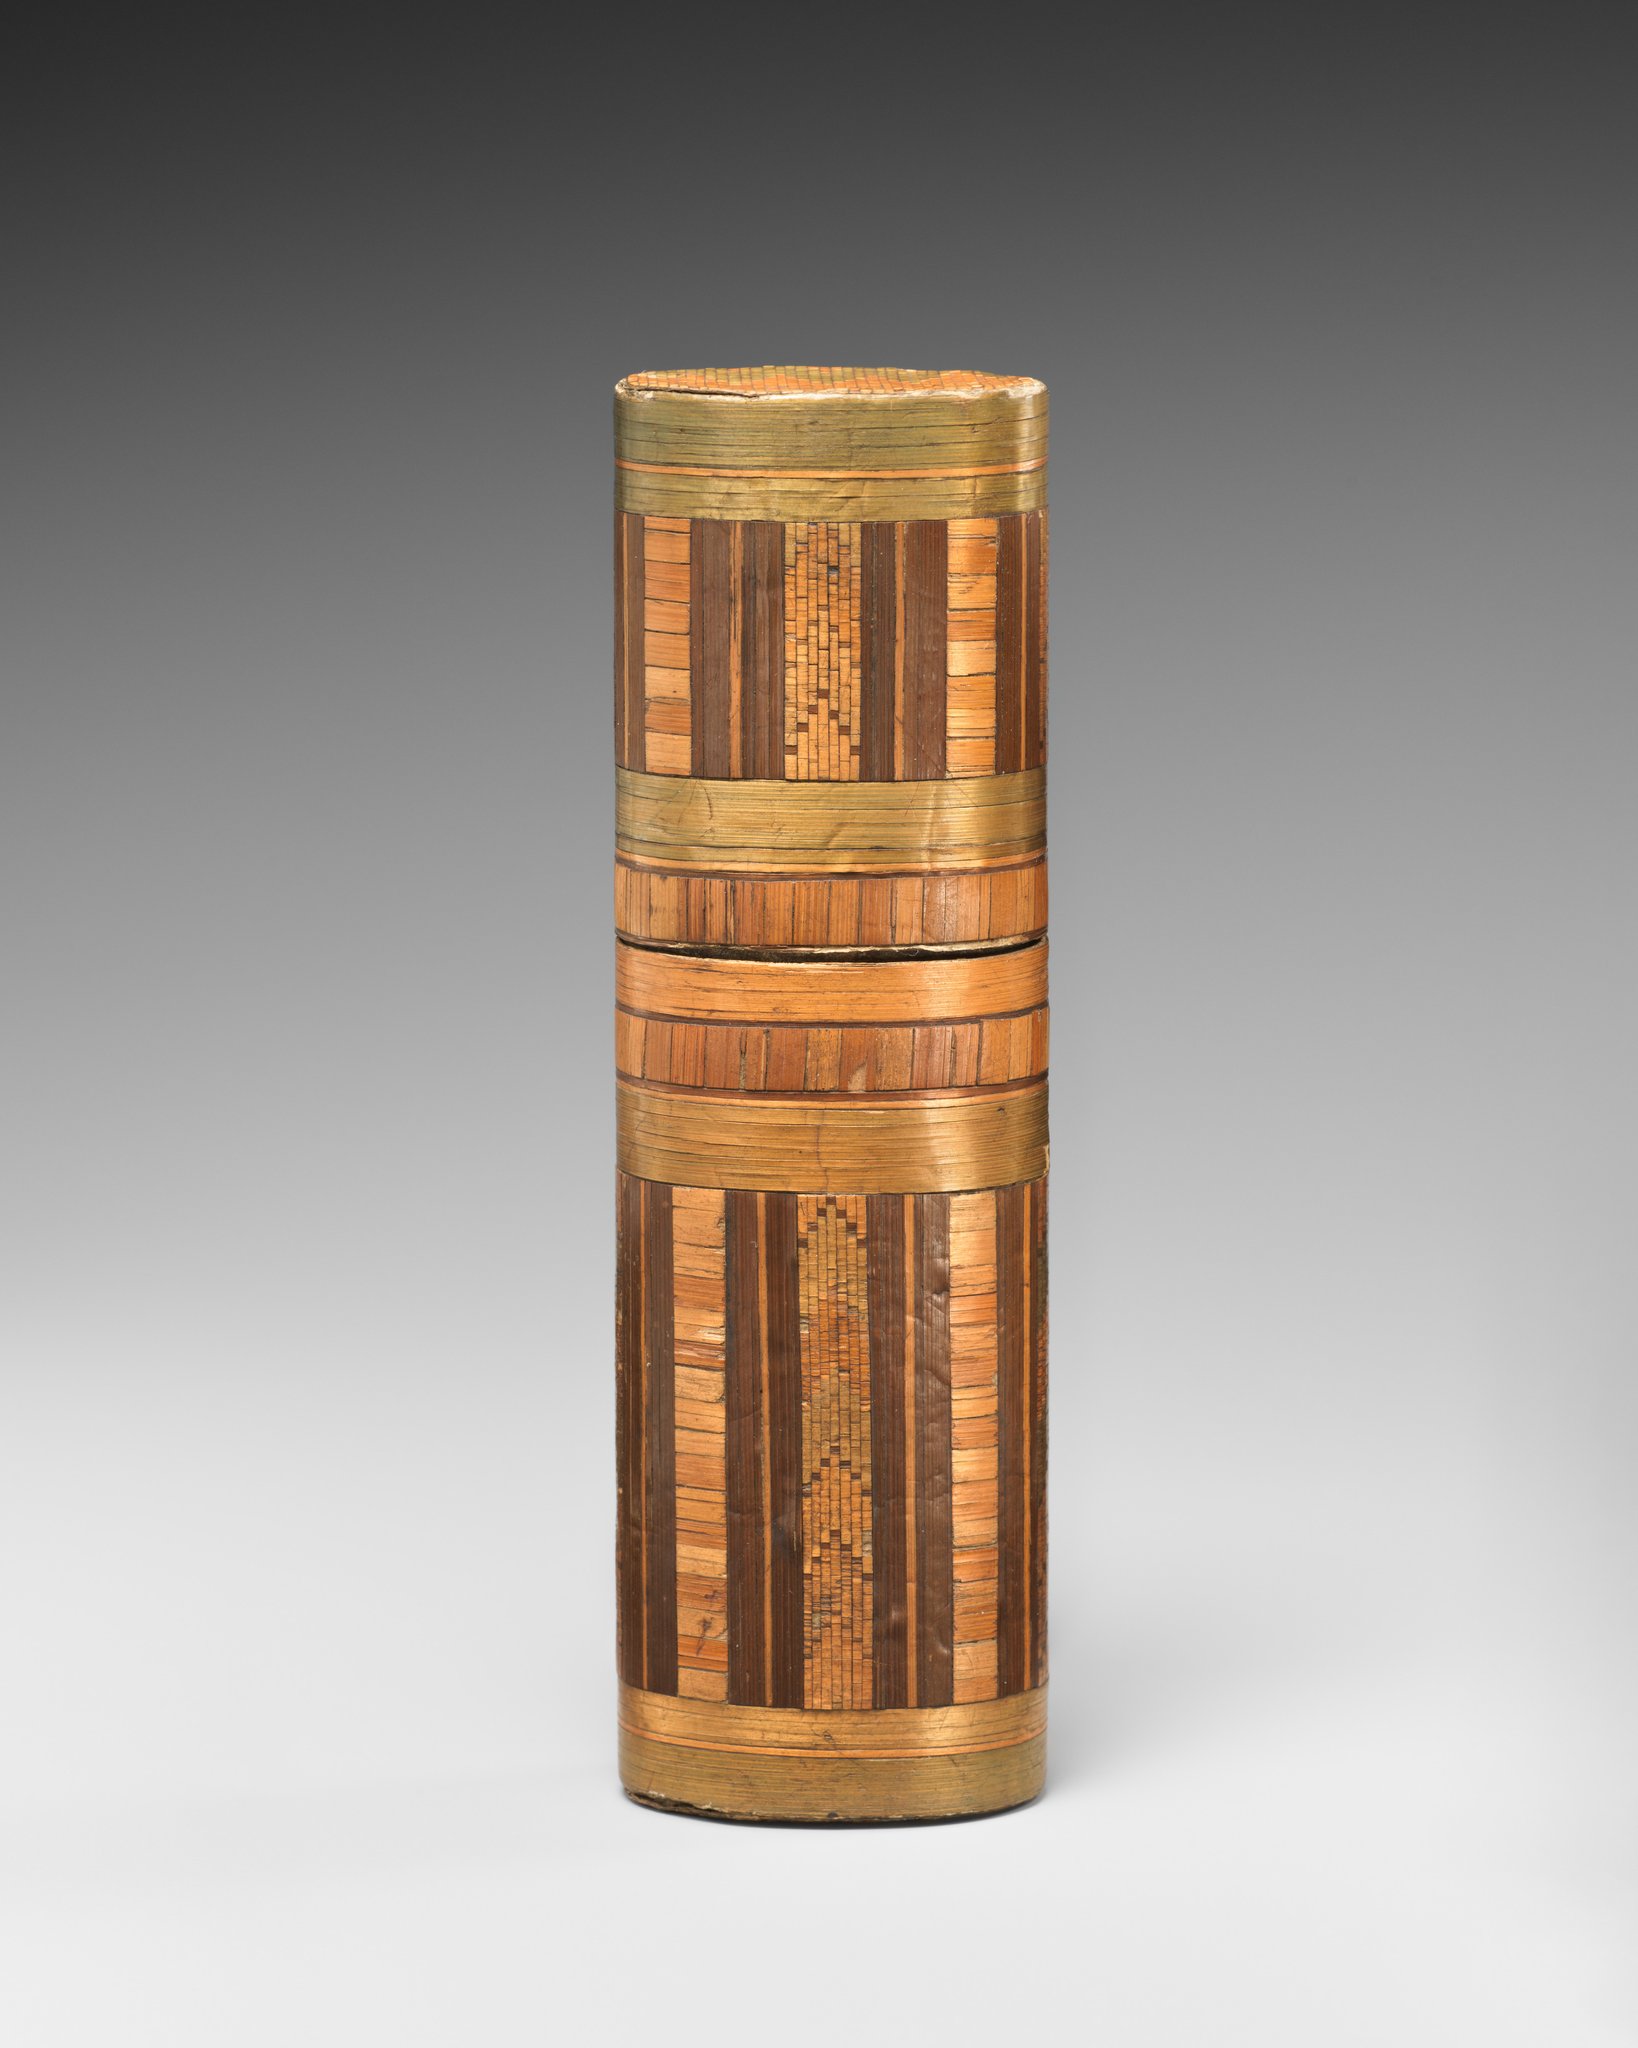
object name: étui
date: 1701-1800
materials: paper, fiber